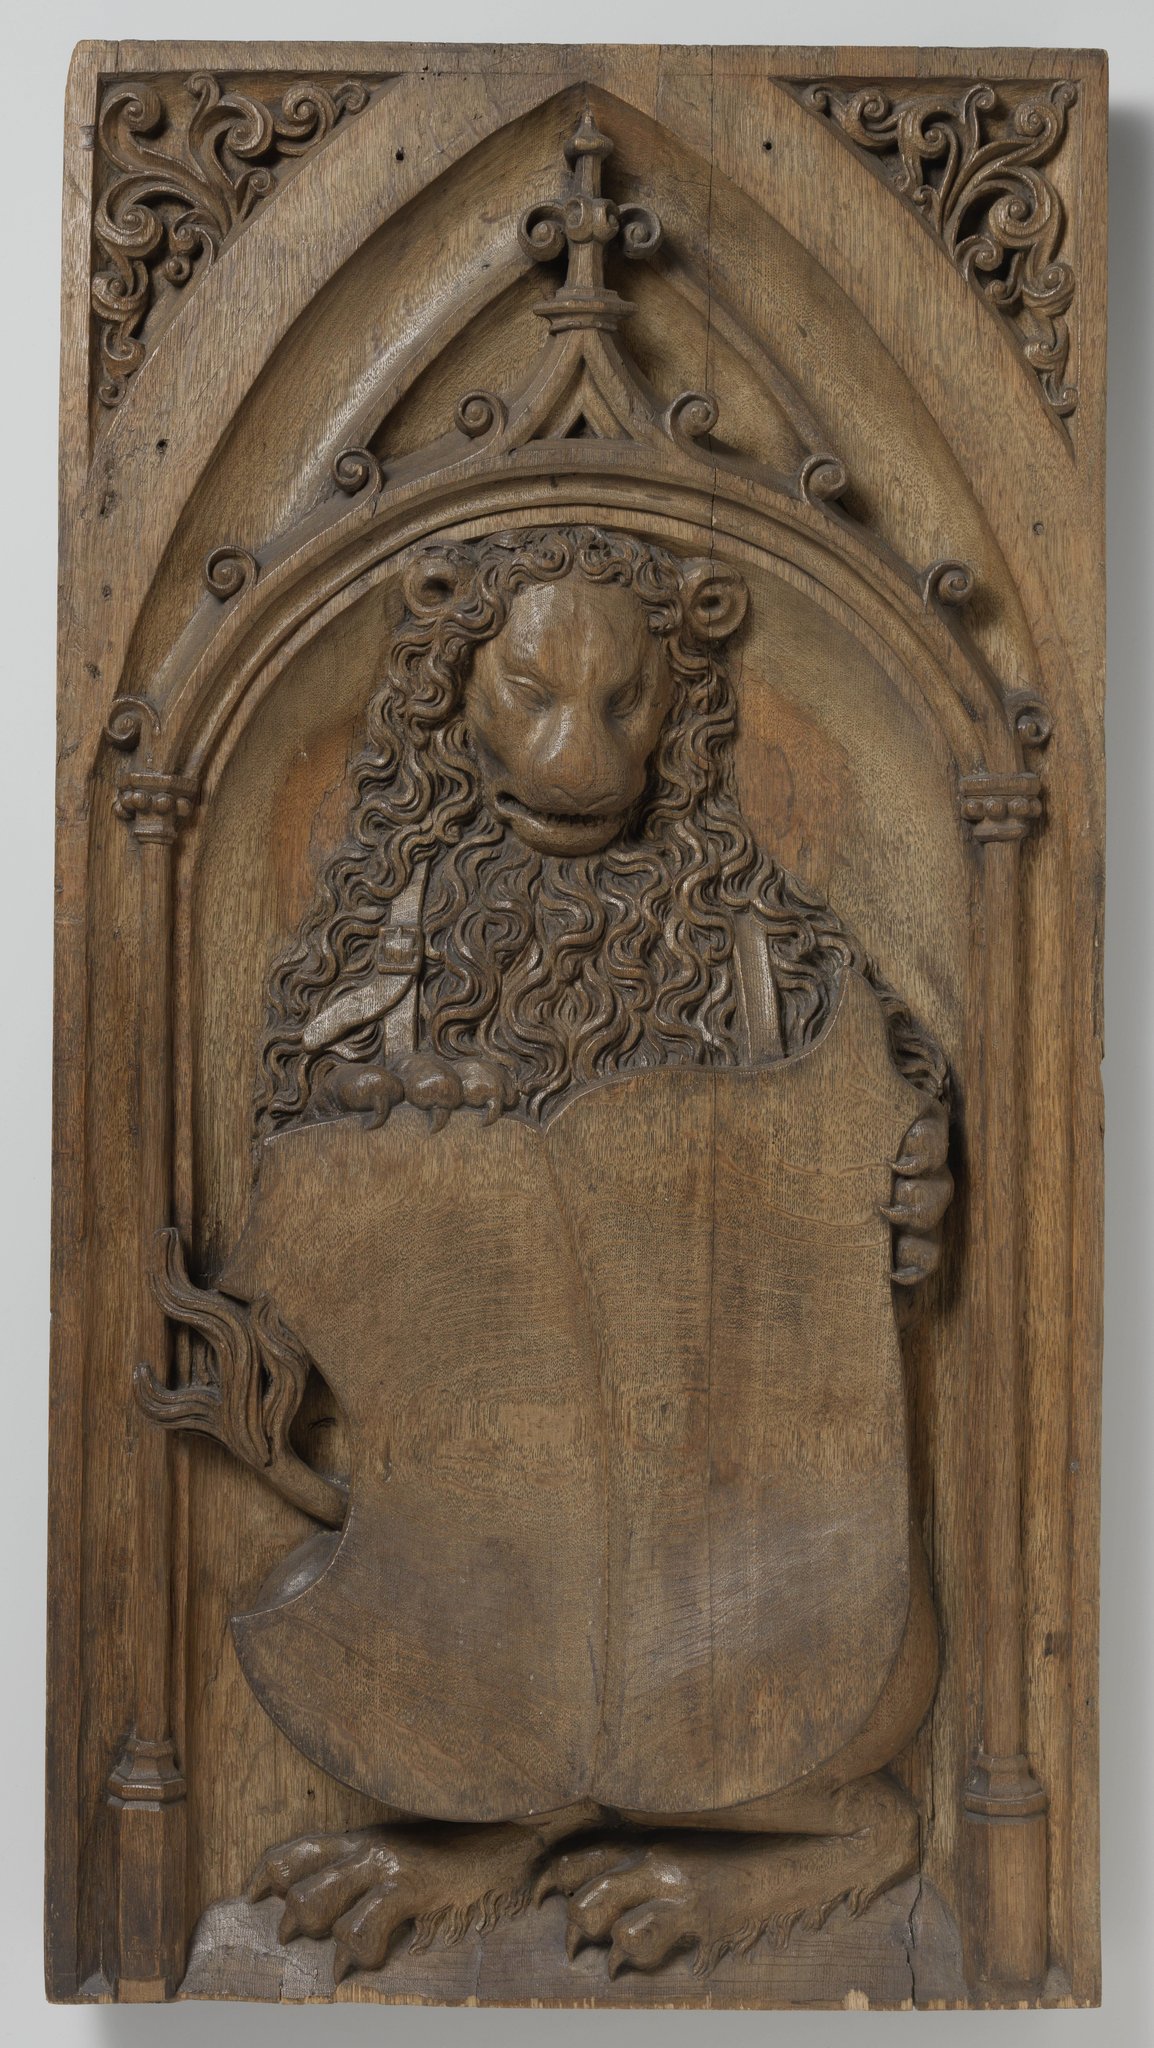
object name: orgelkast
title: Panel with a Lion Supporting an Escutcheon, from the Organ of the Sint-Vituskerk, Naarden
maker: jan eerstensz van schayck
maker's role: sculptor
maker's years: 1470-1527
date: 1510-1520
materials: wood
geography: utrecht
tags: beasts of prey, predatory animals: lion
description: These ten figures adorned the medieval organ in the church of Saint Vitus in Naarden. Each figure holds a weapon and a coat of arms on a strap. Some are dressed as knights with a breastplate and a helmet, others as princes or noblemen. They may represent the Counts of Holland. All the shields would have originally been painted.